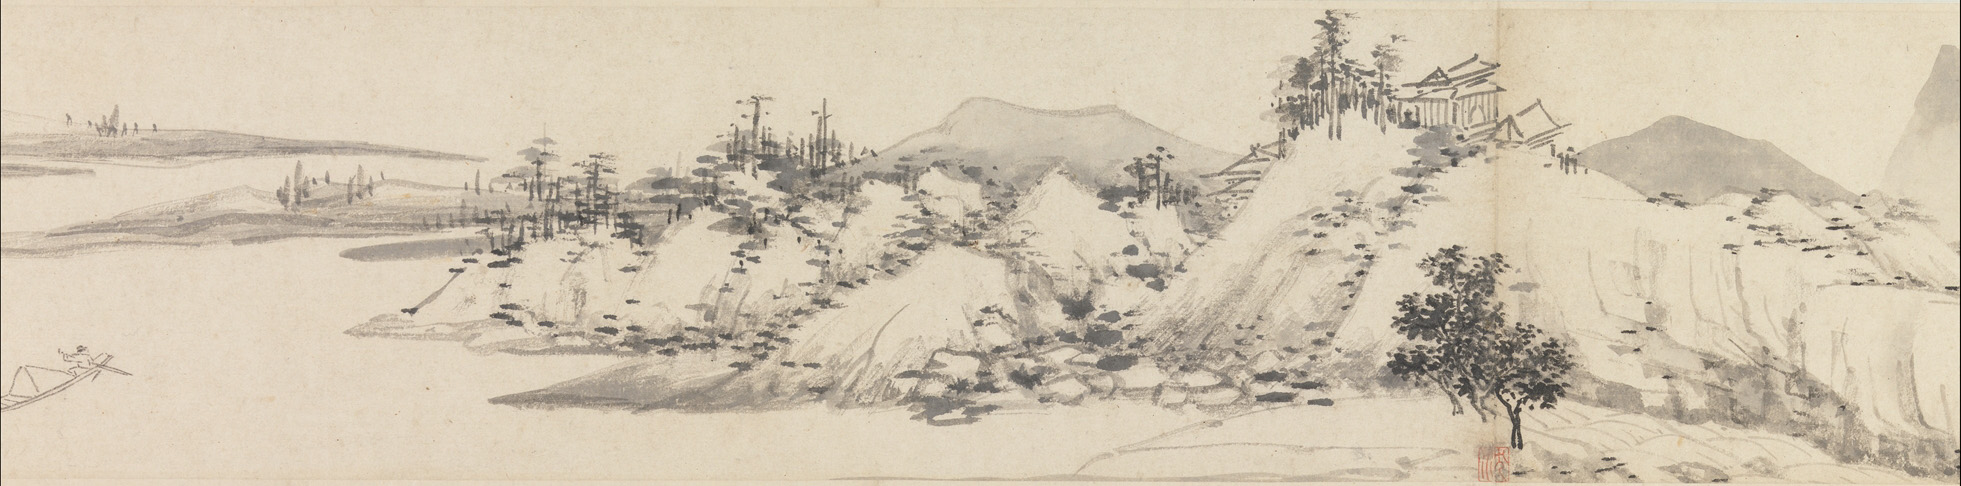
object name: handscroll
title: Autumn Colors among Streams and Mountains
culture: chinese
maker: shen zhou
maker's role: artist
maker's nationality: chinese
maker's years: 1427-1509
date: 1490-1500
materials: ink, paper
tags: mountains,landscapes